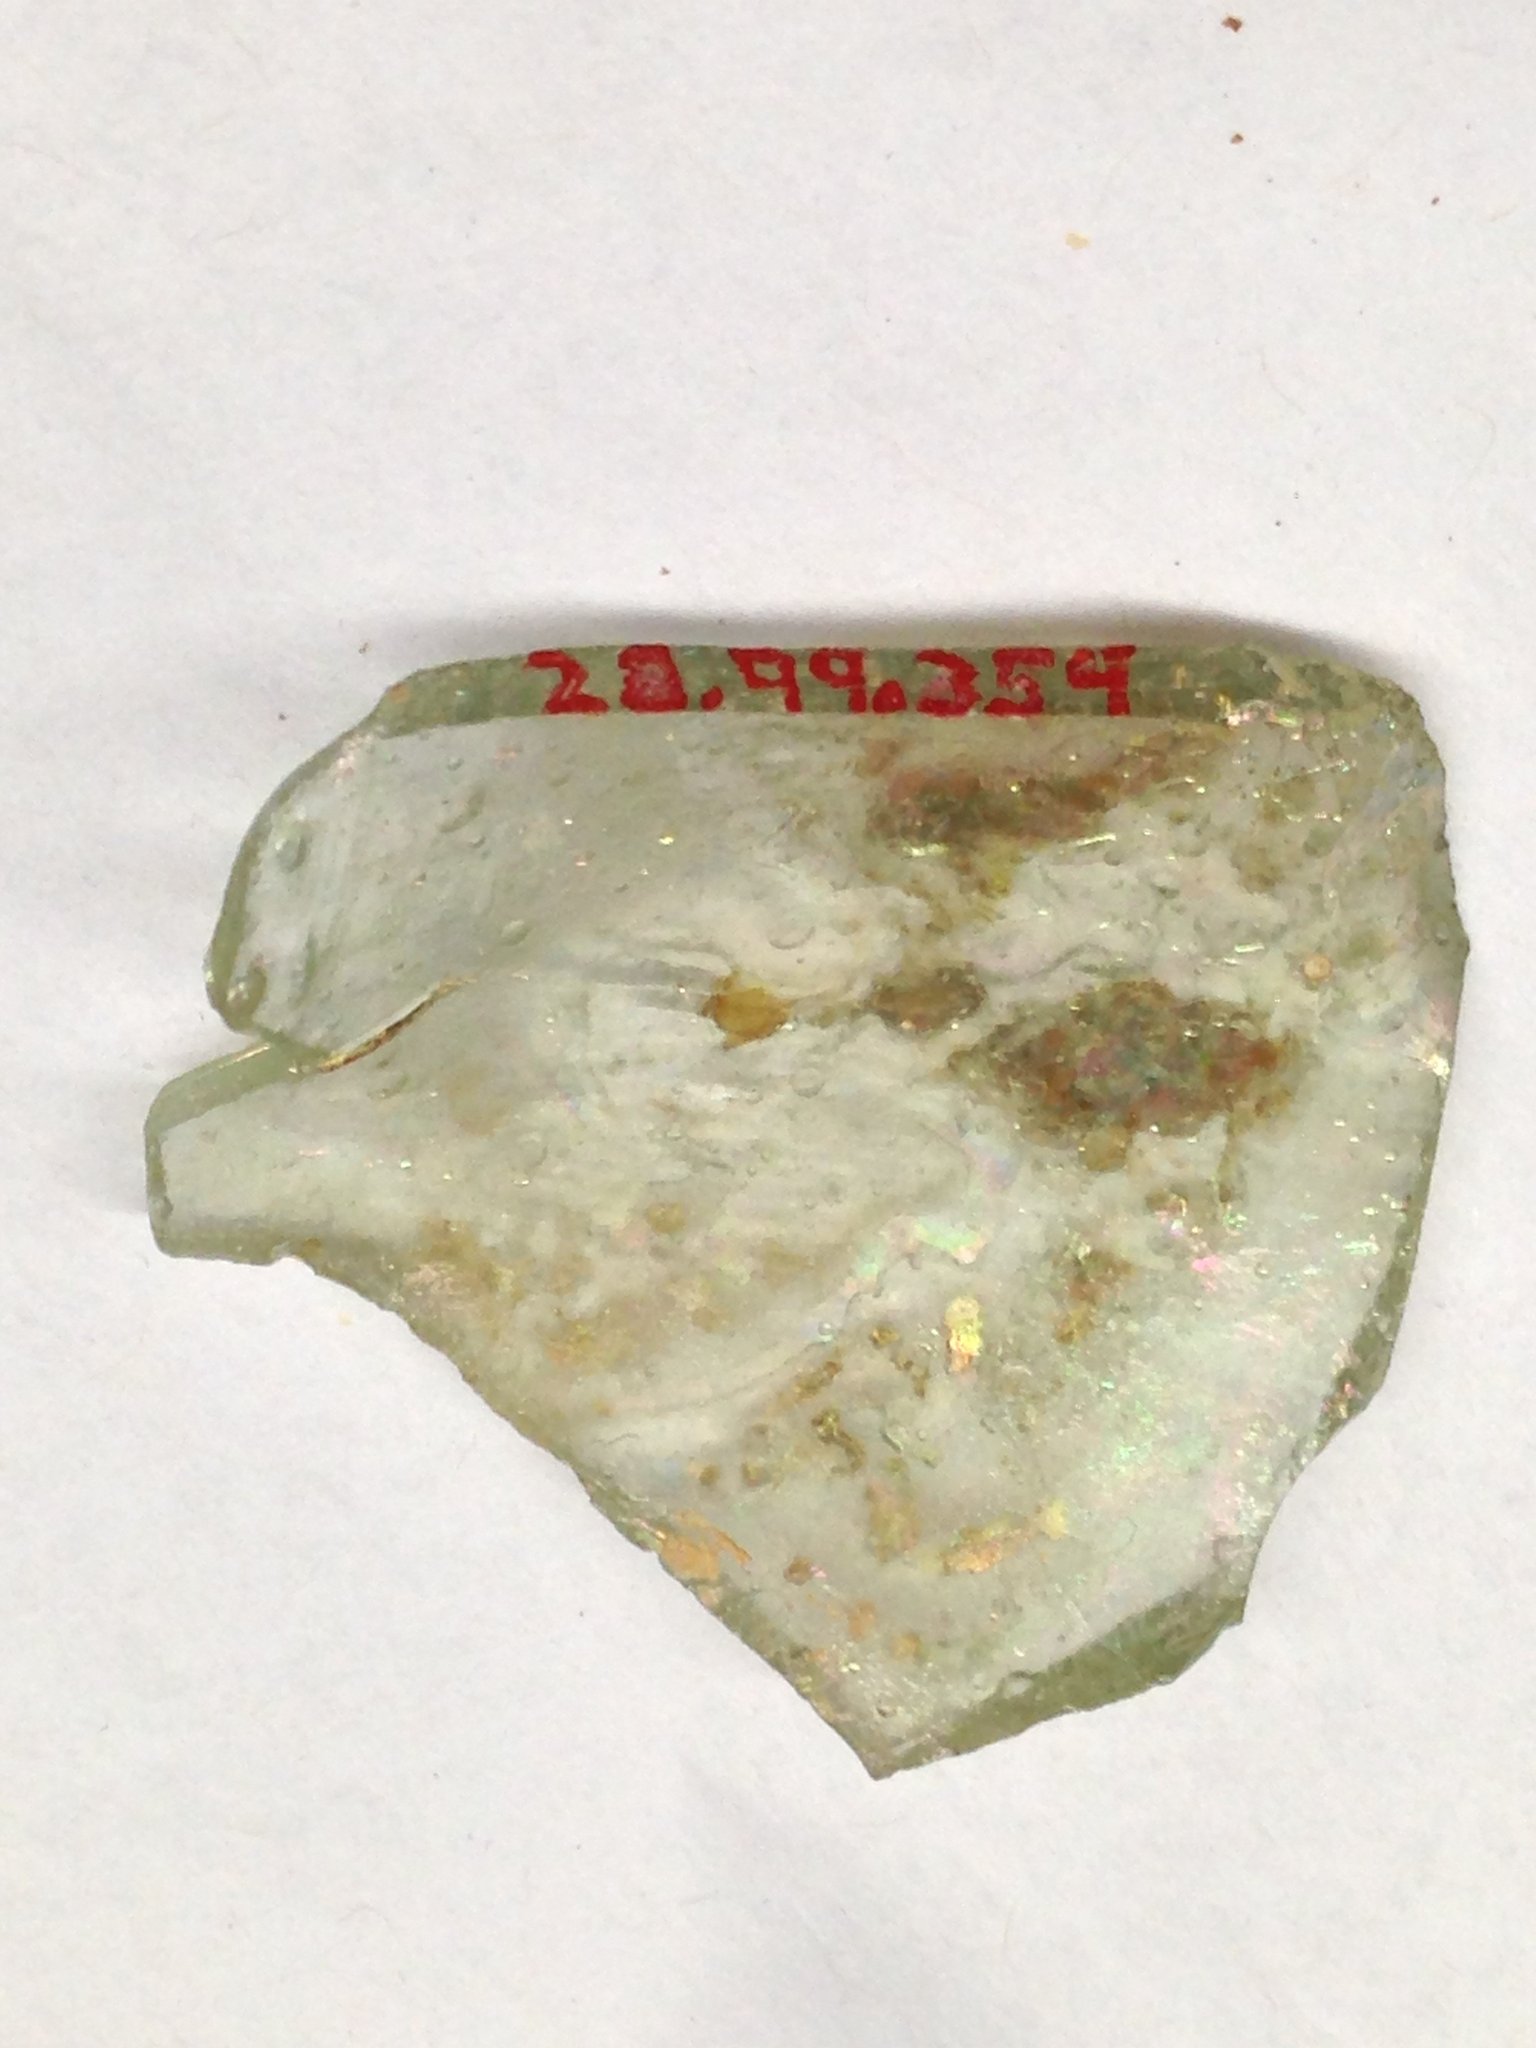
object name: fragment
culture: european or middle eastern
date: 1150-1250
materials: ceramic, glass